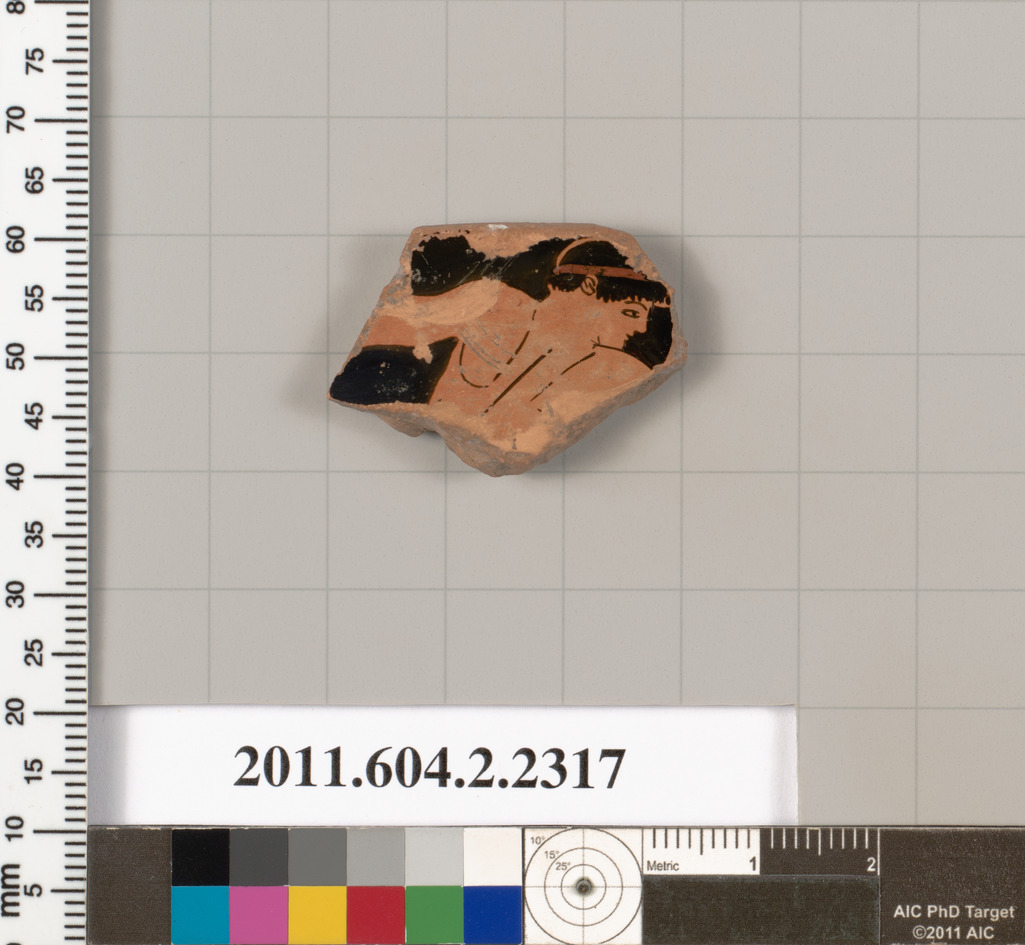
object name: rhyton fragment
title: Terracotta fragment of a rhyton (vase for libations and drinking)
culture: greek, attic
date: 490-470 BCE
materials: terracotta